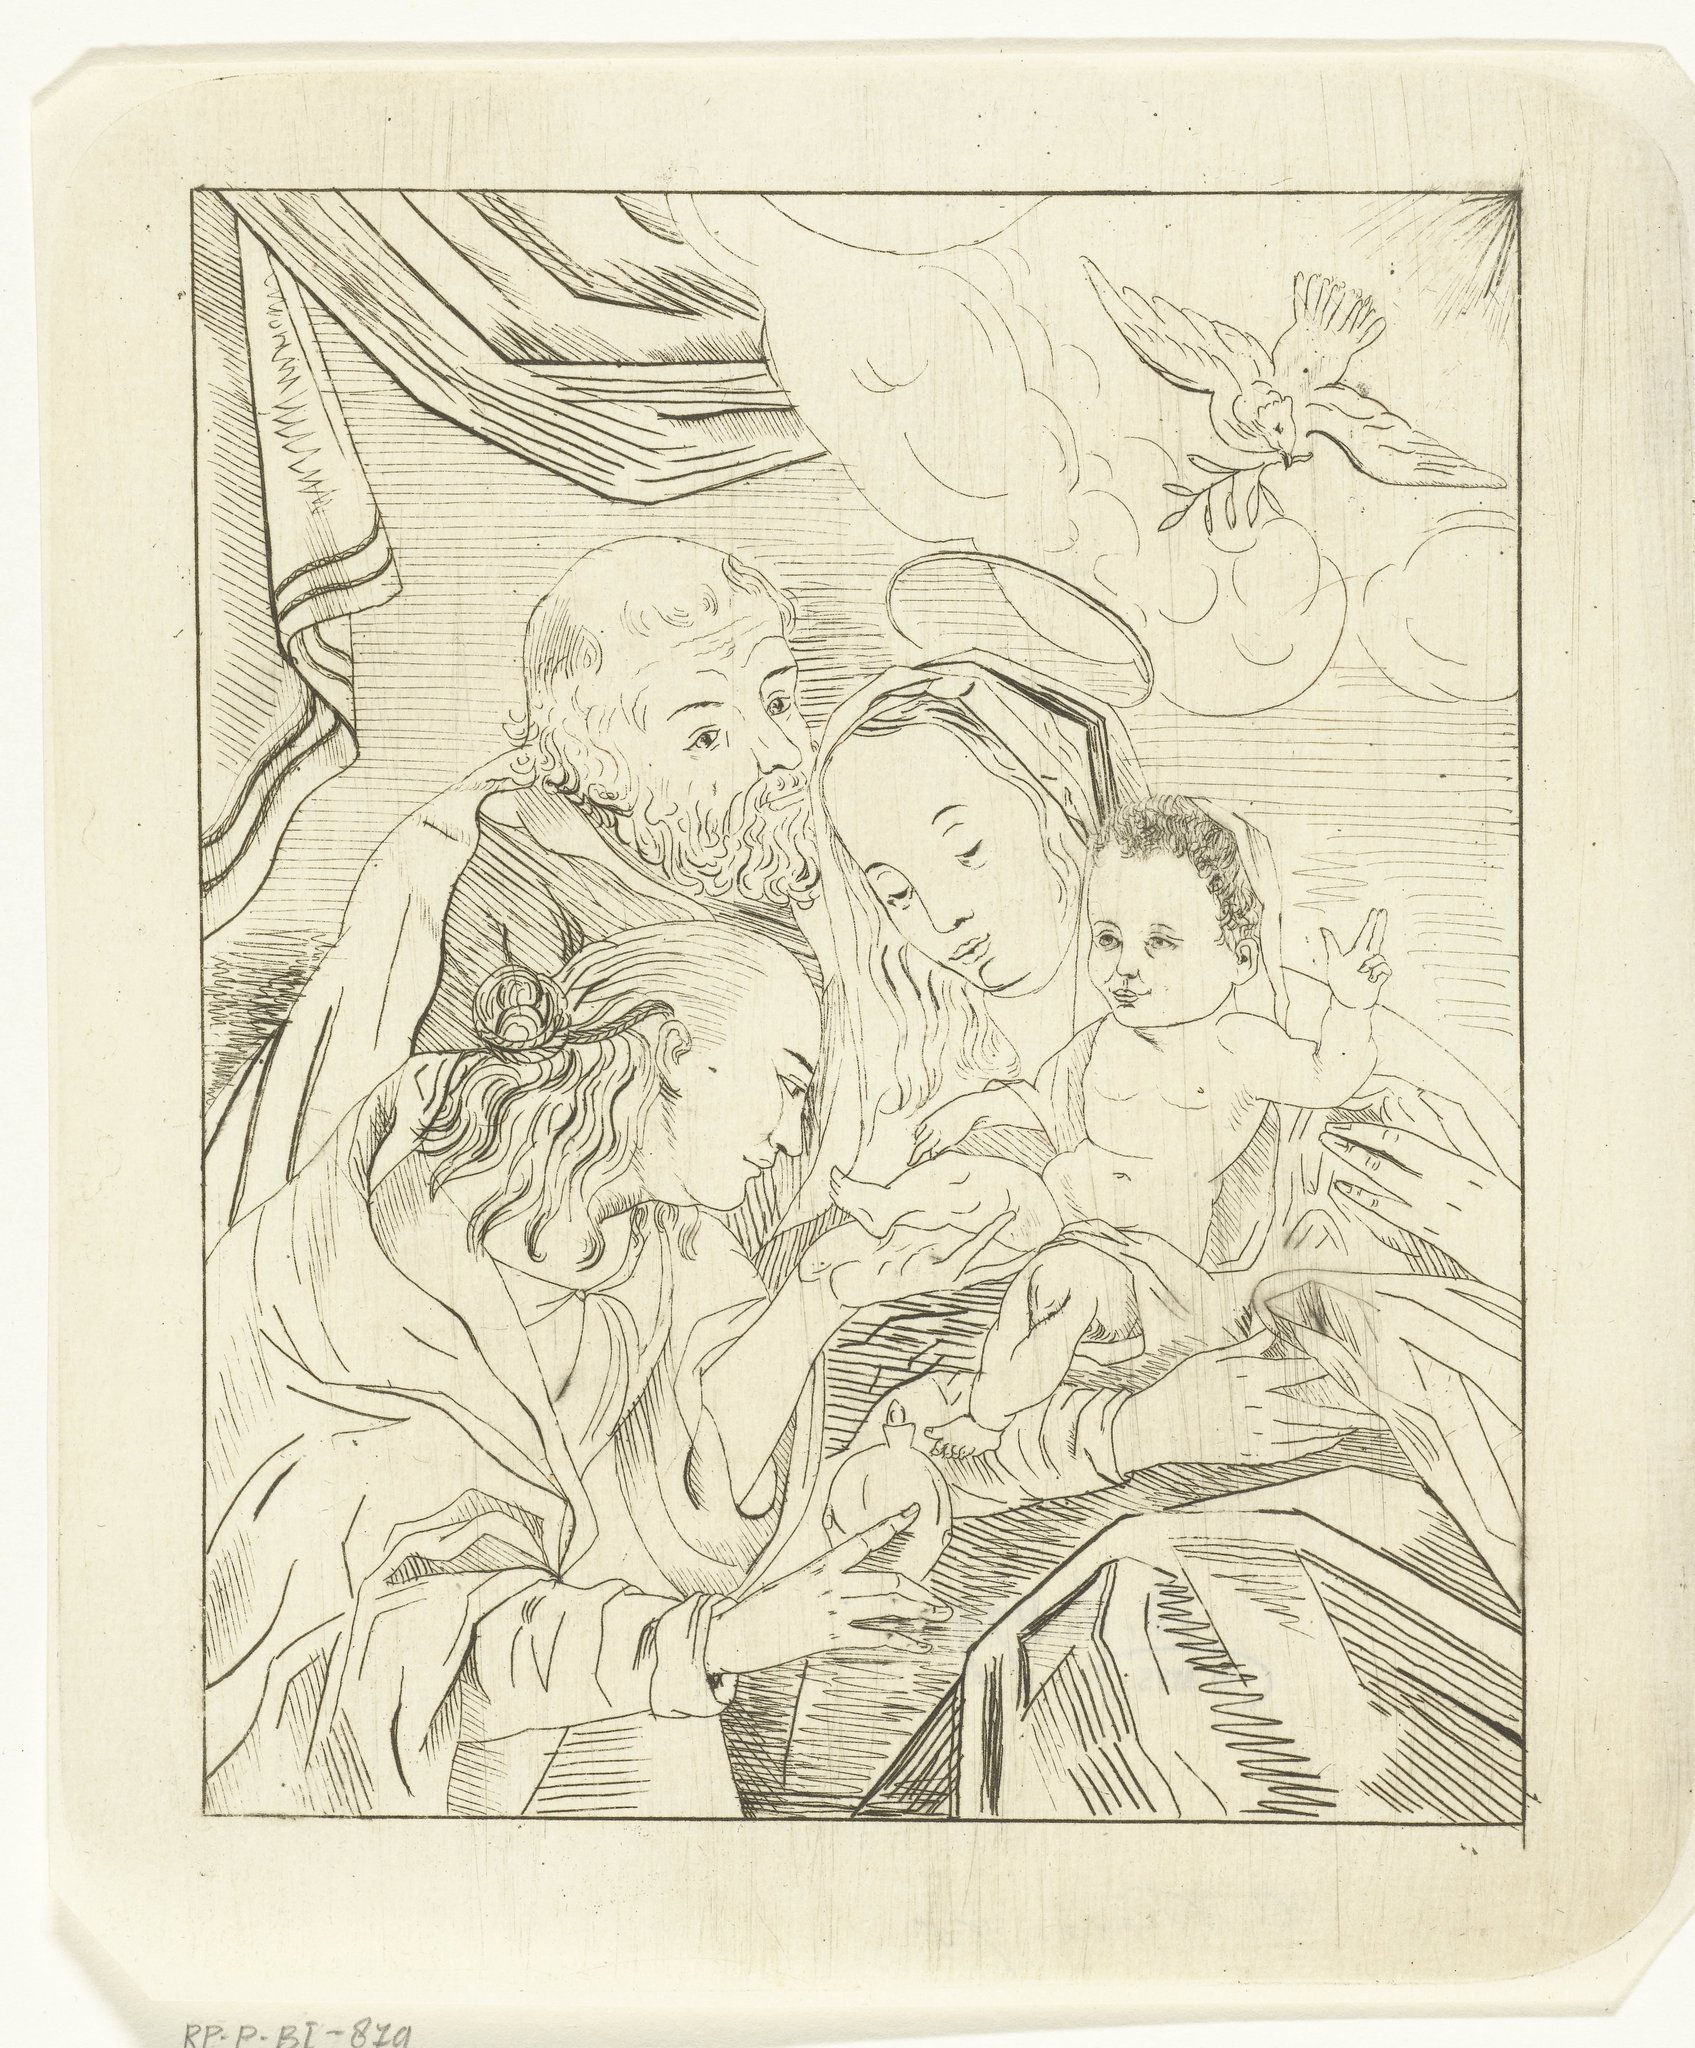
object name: print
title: Aanbidding van het Christuskind door man met geschenk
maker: jonkheer isaac lambertus cremer van den berch van heemstede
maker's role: print maker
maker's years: 1811-1879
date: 1821-1879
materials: paper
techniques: etching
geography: netherlands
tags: adoration of the christ-child ~ christ's birth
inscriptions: collector's mark: Lugt 2228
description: Maria zit met Christuskind op schoot en Jozef achter haar. Een man, mogelijk een koning, of vrouw knielt voor het Kind met een geschenk in de hand. Boven hen verschijnt een duif met een olijftak.